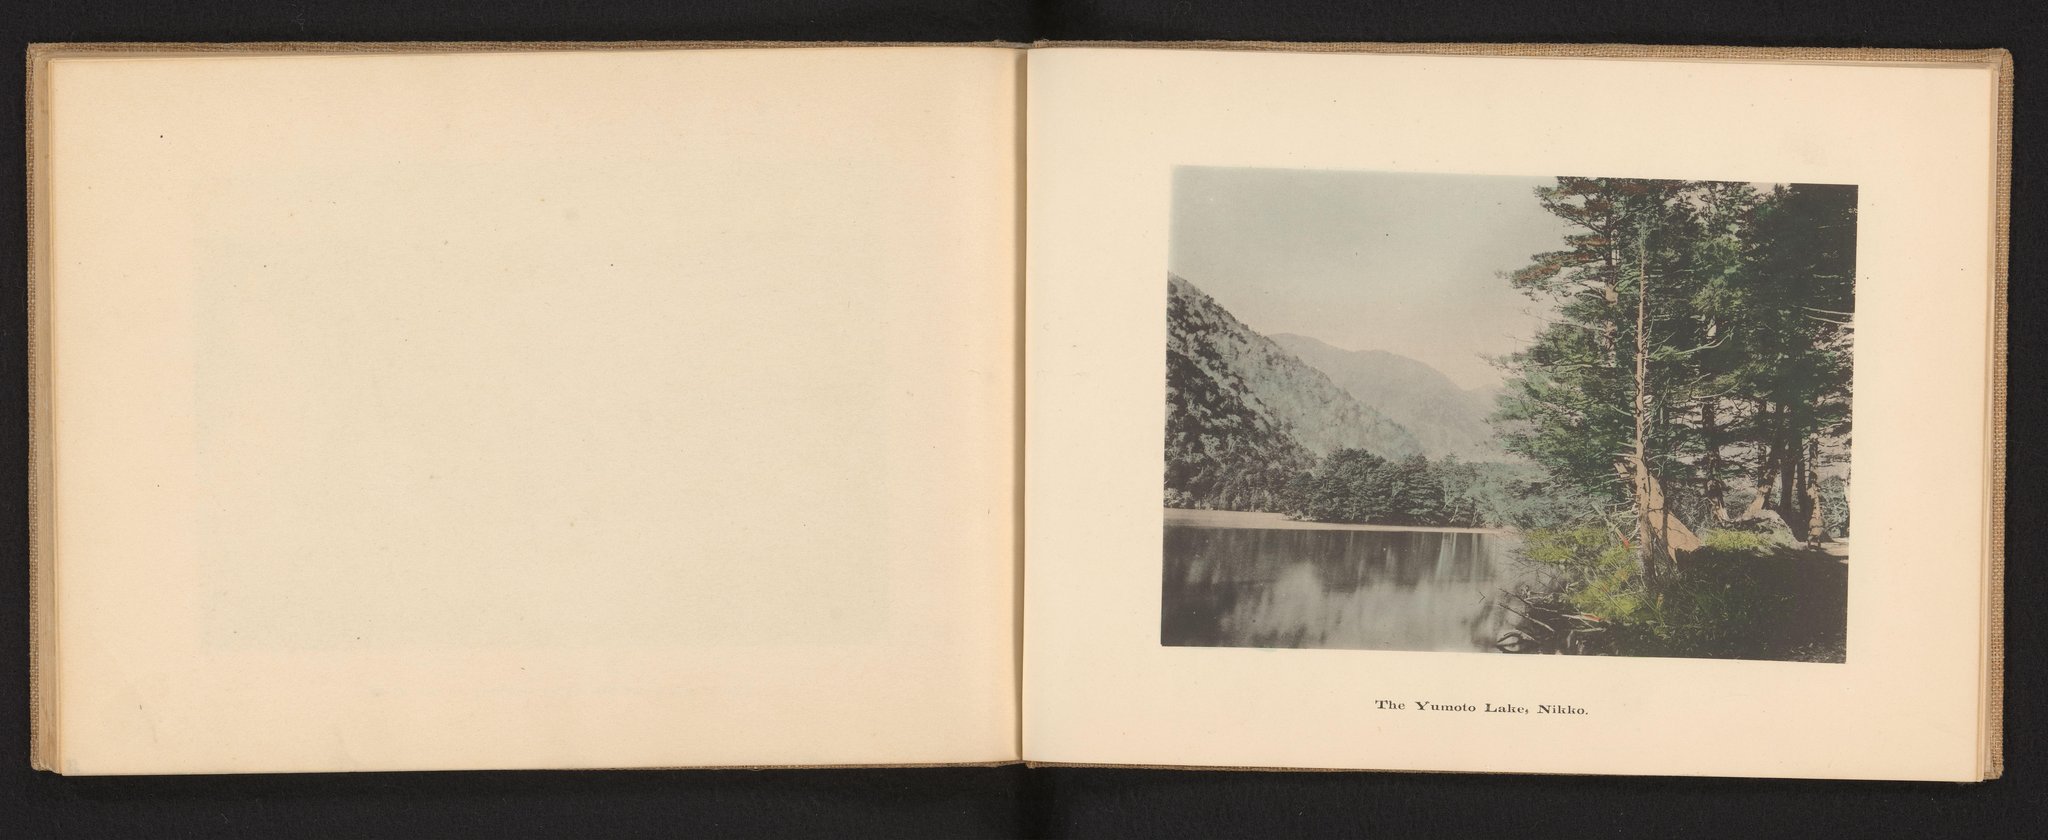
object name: page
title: Gezicht op een meer in Japan, vermoedelijk het Yunokomeer bij Nikko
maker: kōzaburō tamamura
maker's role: fotograaf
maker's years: 1856-1923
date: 1895-1905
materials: paper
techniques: photograph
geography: japan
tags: lake